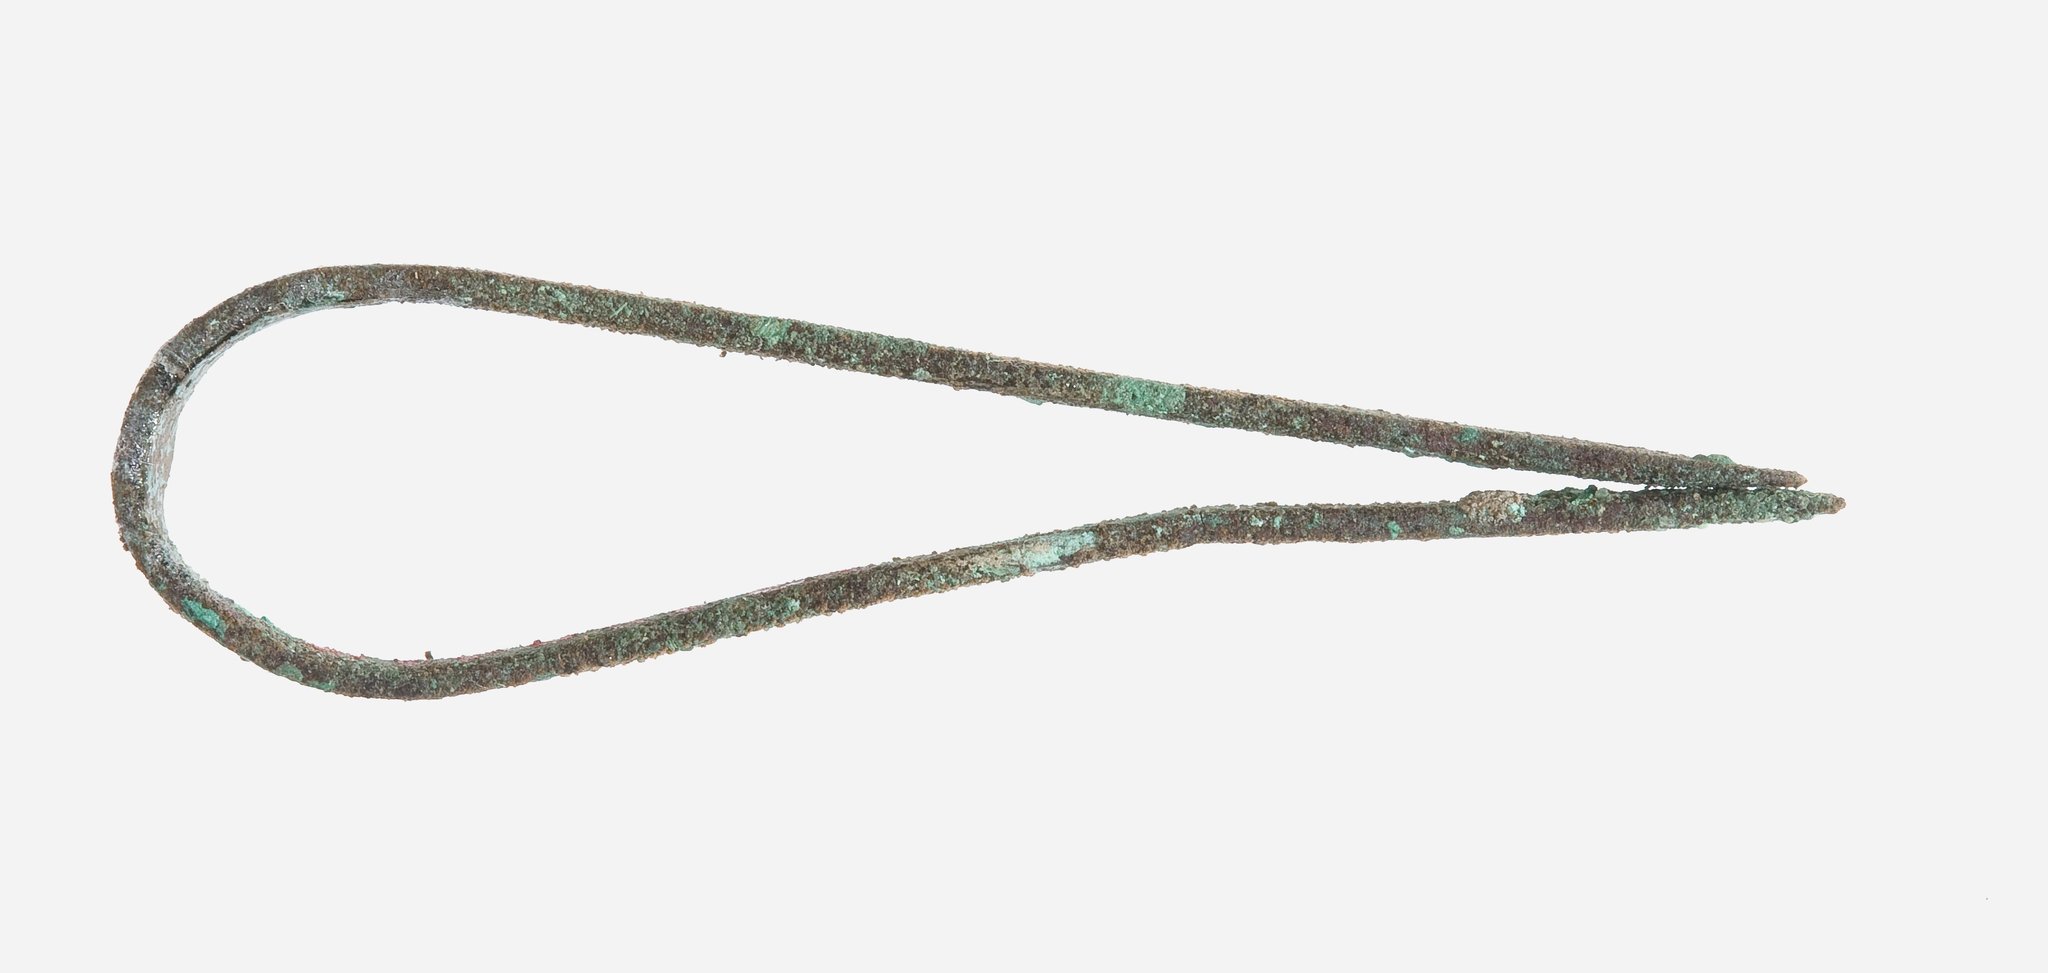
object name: tweezer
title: Tweezers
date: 1390-1352 BCE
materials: bronze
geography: egypt